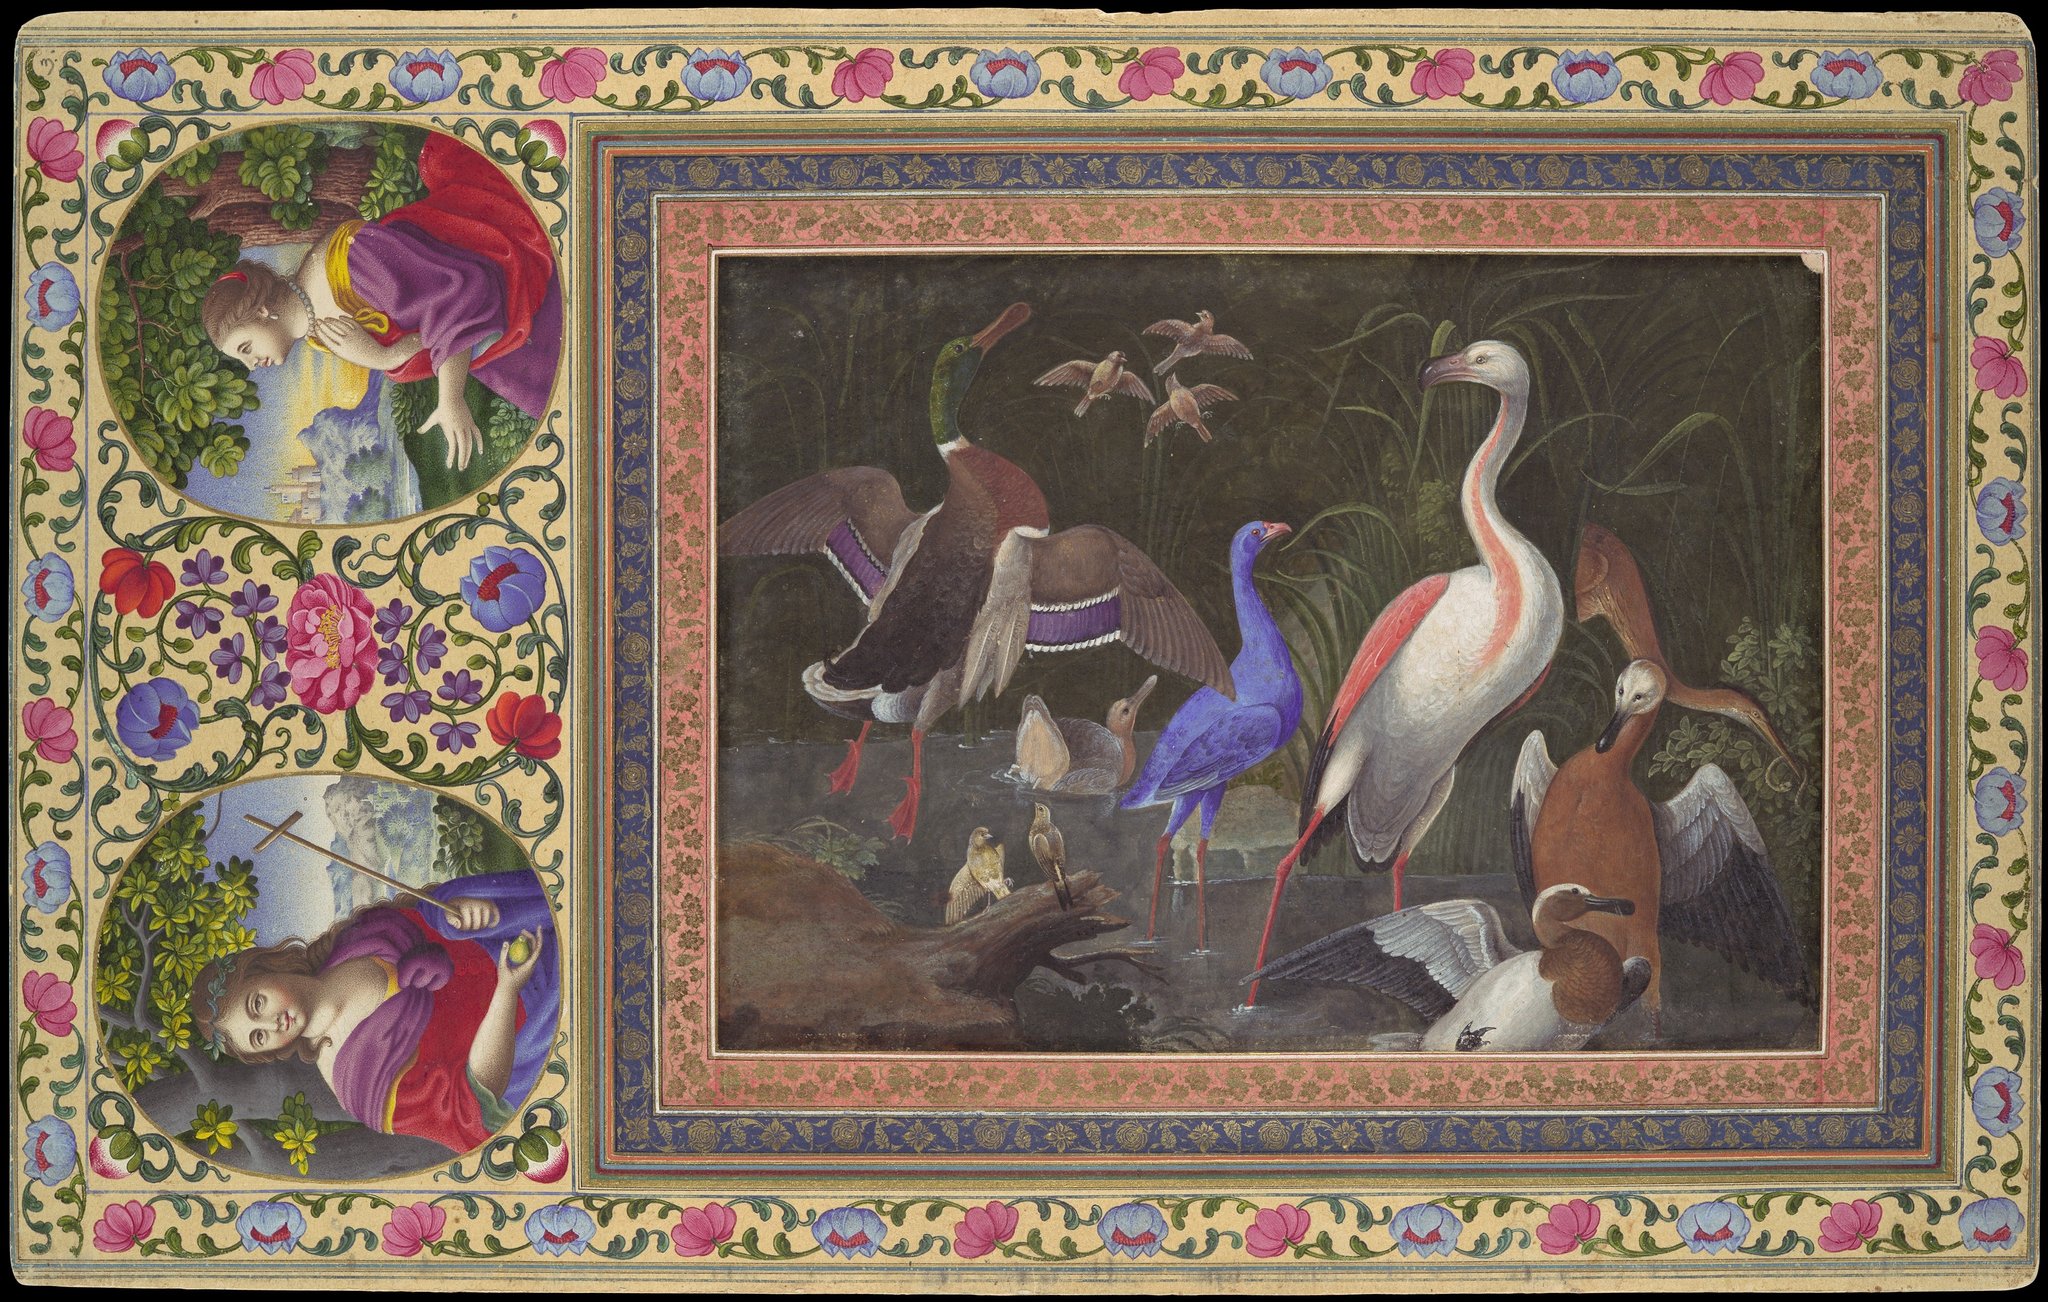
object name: illustrated album leaf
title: "Aquatic Birds at a Pool", Folio from the Davis Album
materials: gold, ink, paper, watercolor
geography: iran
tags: birds,profiles,women,cross